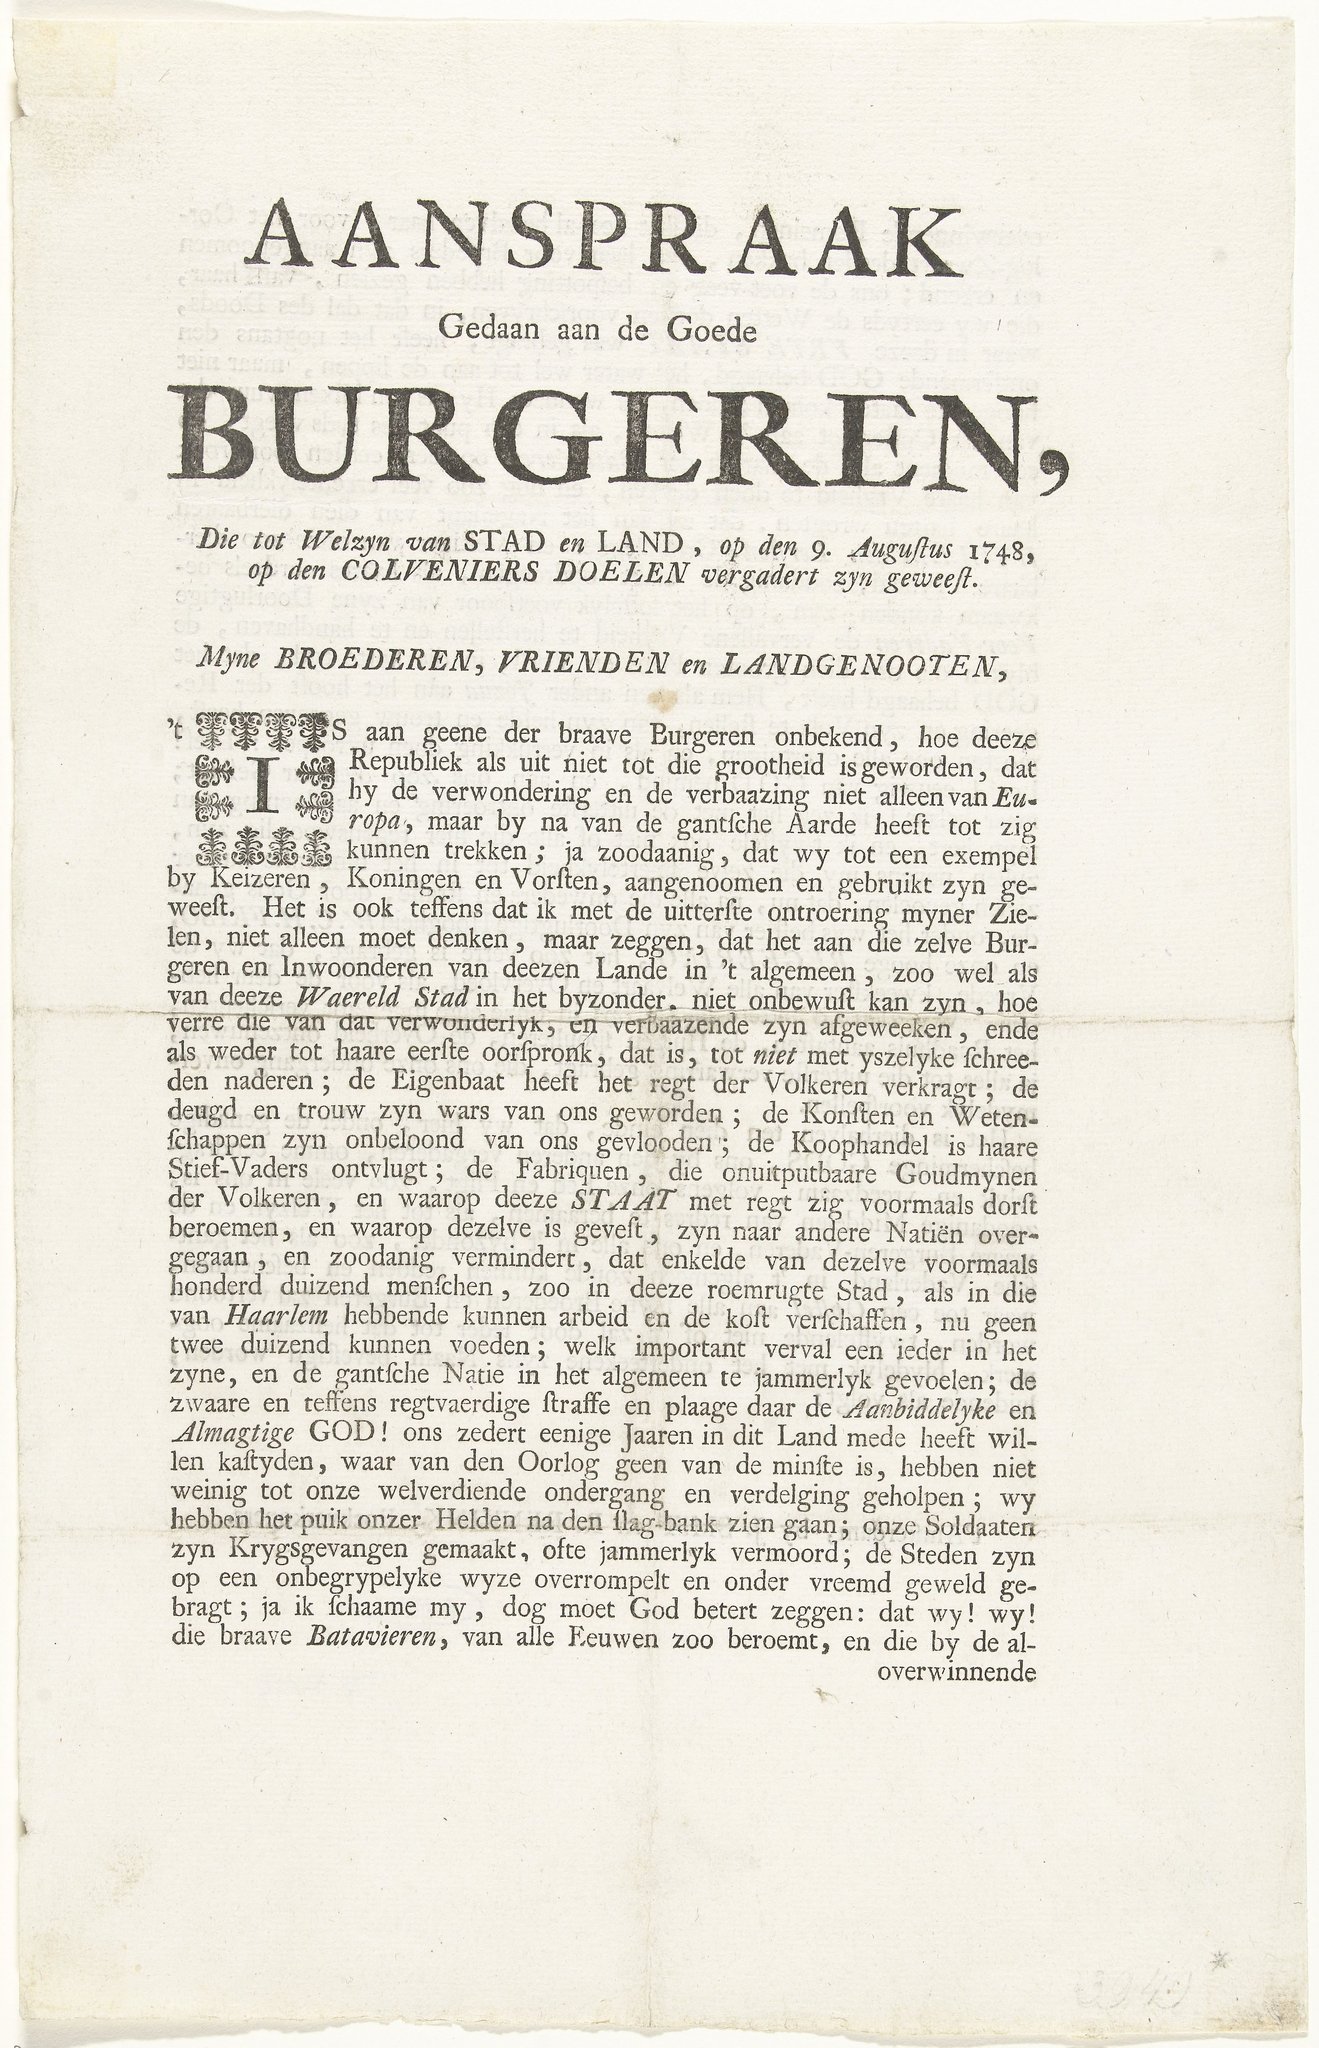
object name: text sheet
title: Aanspraak aan de Doelisten, 1748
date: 1748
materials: paper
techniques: letterpress printing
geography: amsterdam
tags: kloveniersdoelen, pachtersoproer (1747-1750)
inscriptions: collector's mark: Lugt 2228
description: Tekstblad met de tekst van de aanspraak gedaan aan de Patriotten (Doelisten) die in de openbare vergadering in de Kloveniersdoelen te Amsterdam op 9 augustus 1748 bijeen zijn geweest. Blad op beide zijden bedrukt.